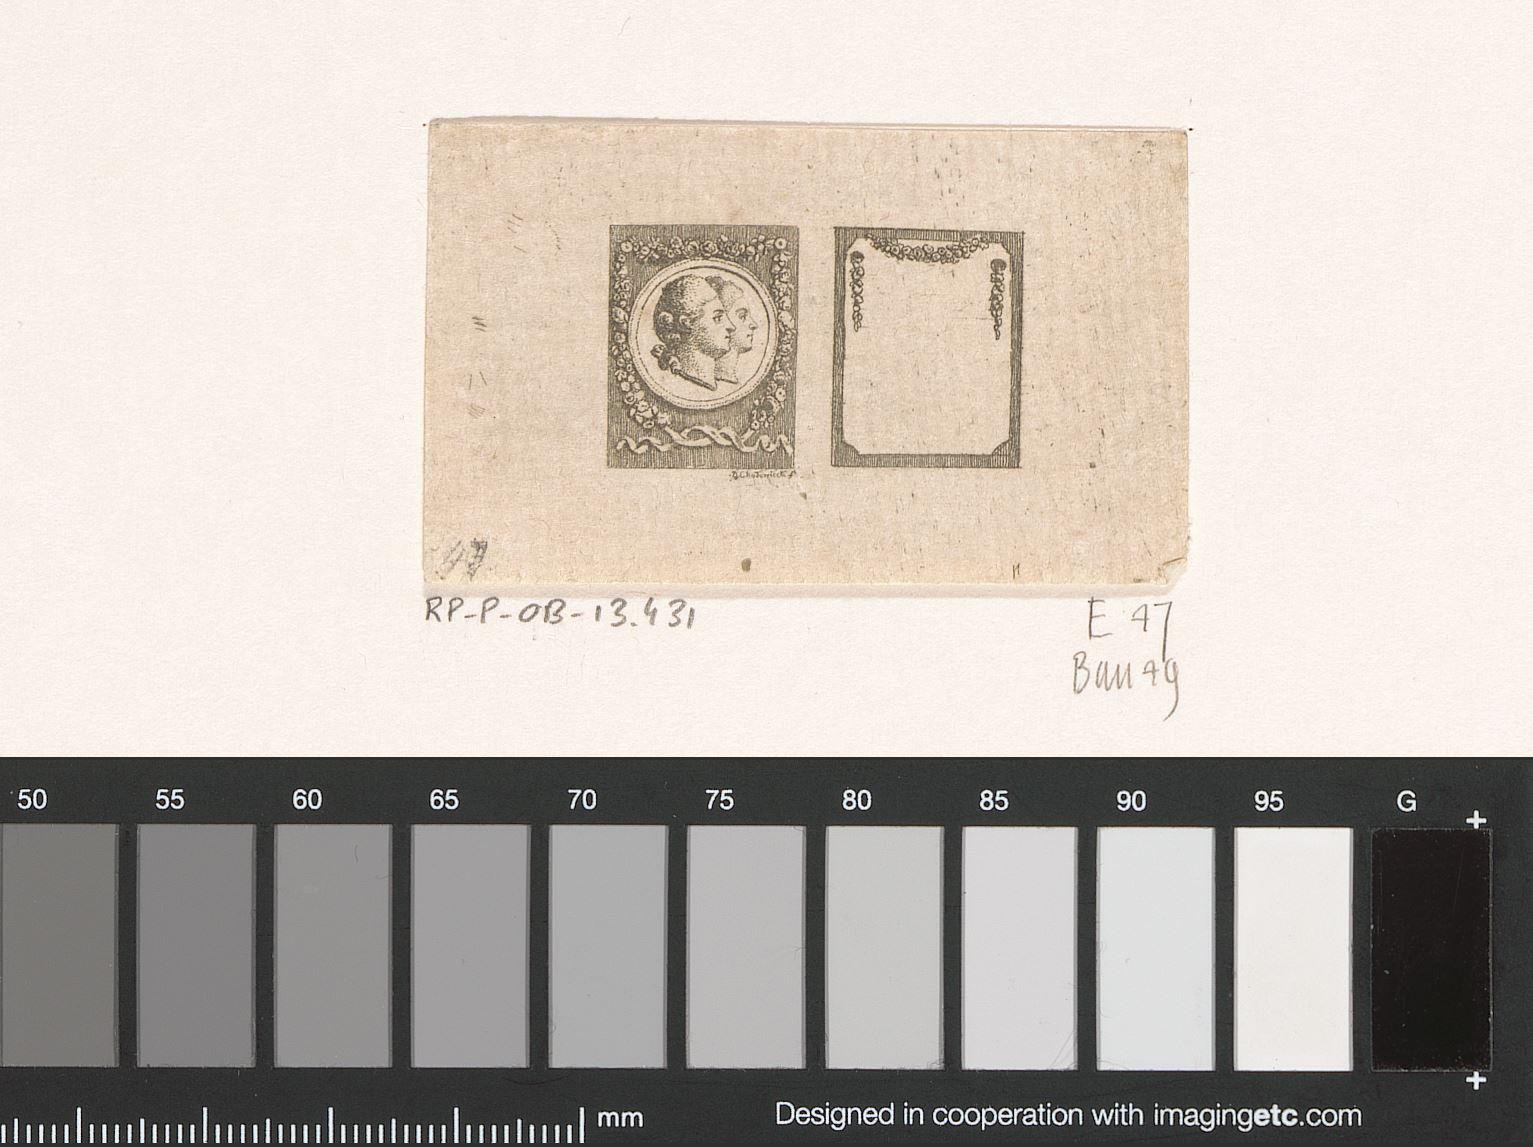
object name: print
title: Portretten van Willem V van Oranje en Wilhelmina van Pruisen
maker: daniel nikolaus chodowiecki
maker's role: draughtsman, print maker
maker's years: 1726-1801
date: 1767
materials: paper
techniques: etching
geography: berlin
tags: the hague, william v (prince of orange), berlin, painter, draughtsman, wilhelmina of prussia (princess of orange), historical persons - bb - woman, historical persons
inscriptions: collector's mark: Lugt 2228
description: Proefdruk voor de titel in het kader rechts. Een latere staat van deze prent is gebruikt als titelpagina voor een tekst van Formey getiteld 'Bouquet de Maximes'. Ter ere van het huwelijk van Willem V en Wilhelmina van Pruisen in 1767 gaf de Berlijnse boekhandelaar E. de Bourdeaux deze tekst uit in een almanak die een hanger gedragen kon worden.